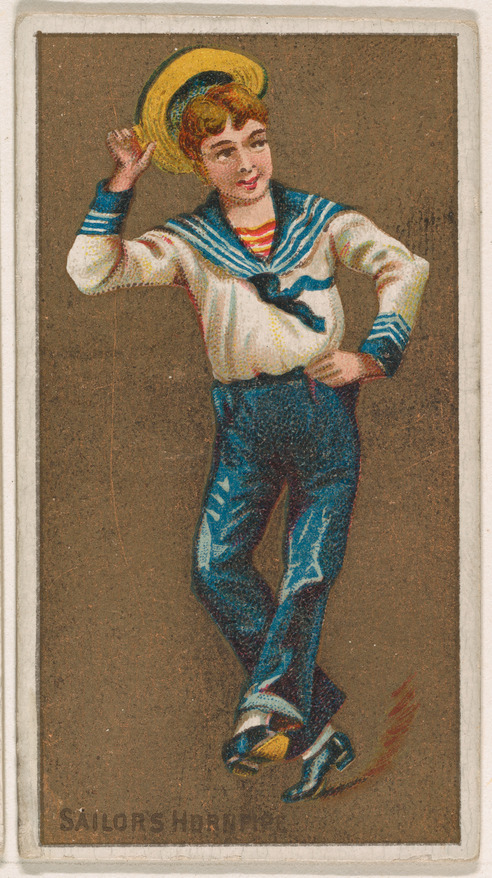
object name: print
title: Sailor's Hornpipe, from National Dances (N225, Type 1) issued by Kinney Bros.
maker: kinney brothers tobacco company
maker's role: publisher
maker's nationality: american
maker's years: 1869-2011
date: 1889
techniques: color lithograph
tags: boys,dancers